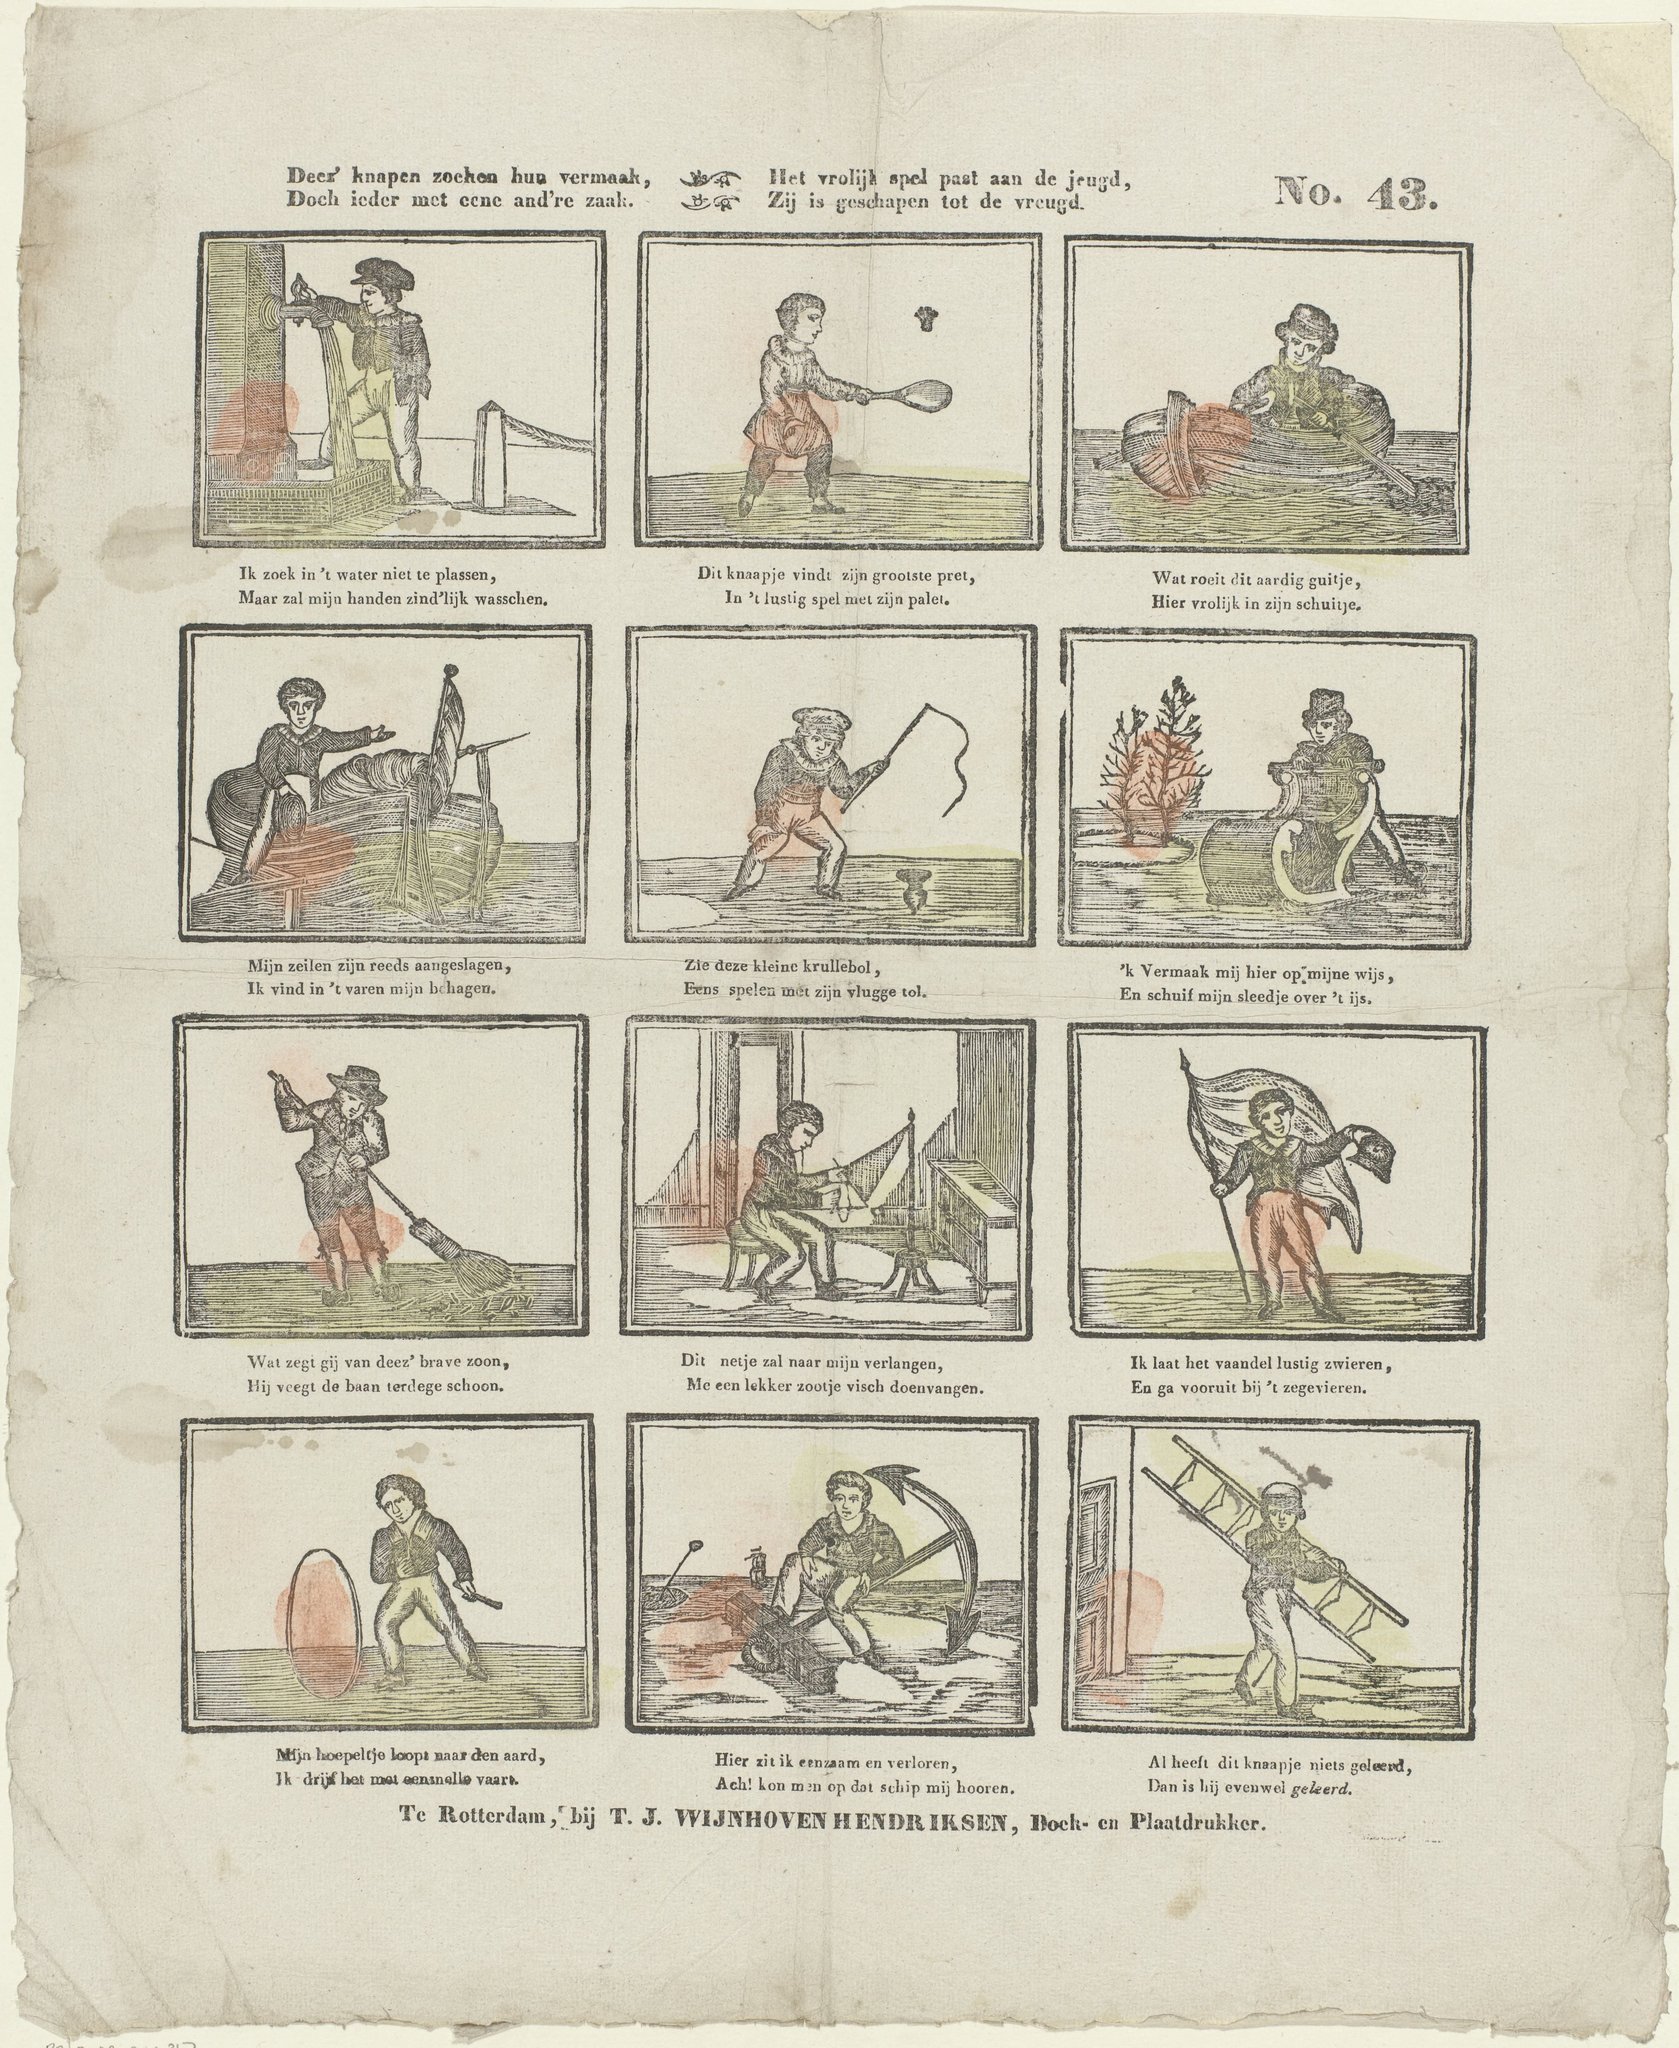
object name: print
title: Deez' knapen zoeken hun vermaak, / Doch ieder met eene and're zaak. / Het vrolijk spel past aan de jeugd. / Zij is geschapen tot de vreugd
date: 1832-1850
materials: paper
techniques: colour, letterpress printing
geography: rotterdam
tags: children's games and plays, games using special objects (marbles, top, hoop, etc.), washing one's hands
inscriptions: collector's mark: Lugt 2760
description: Blad met 12 voorstellingen van kinderspelen en bezigheden, zoals handen wassen, tollen en vegen. Onder elke afbeelding een tweeregelig vers. Genummerd rechtsboven: No. 43.